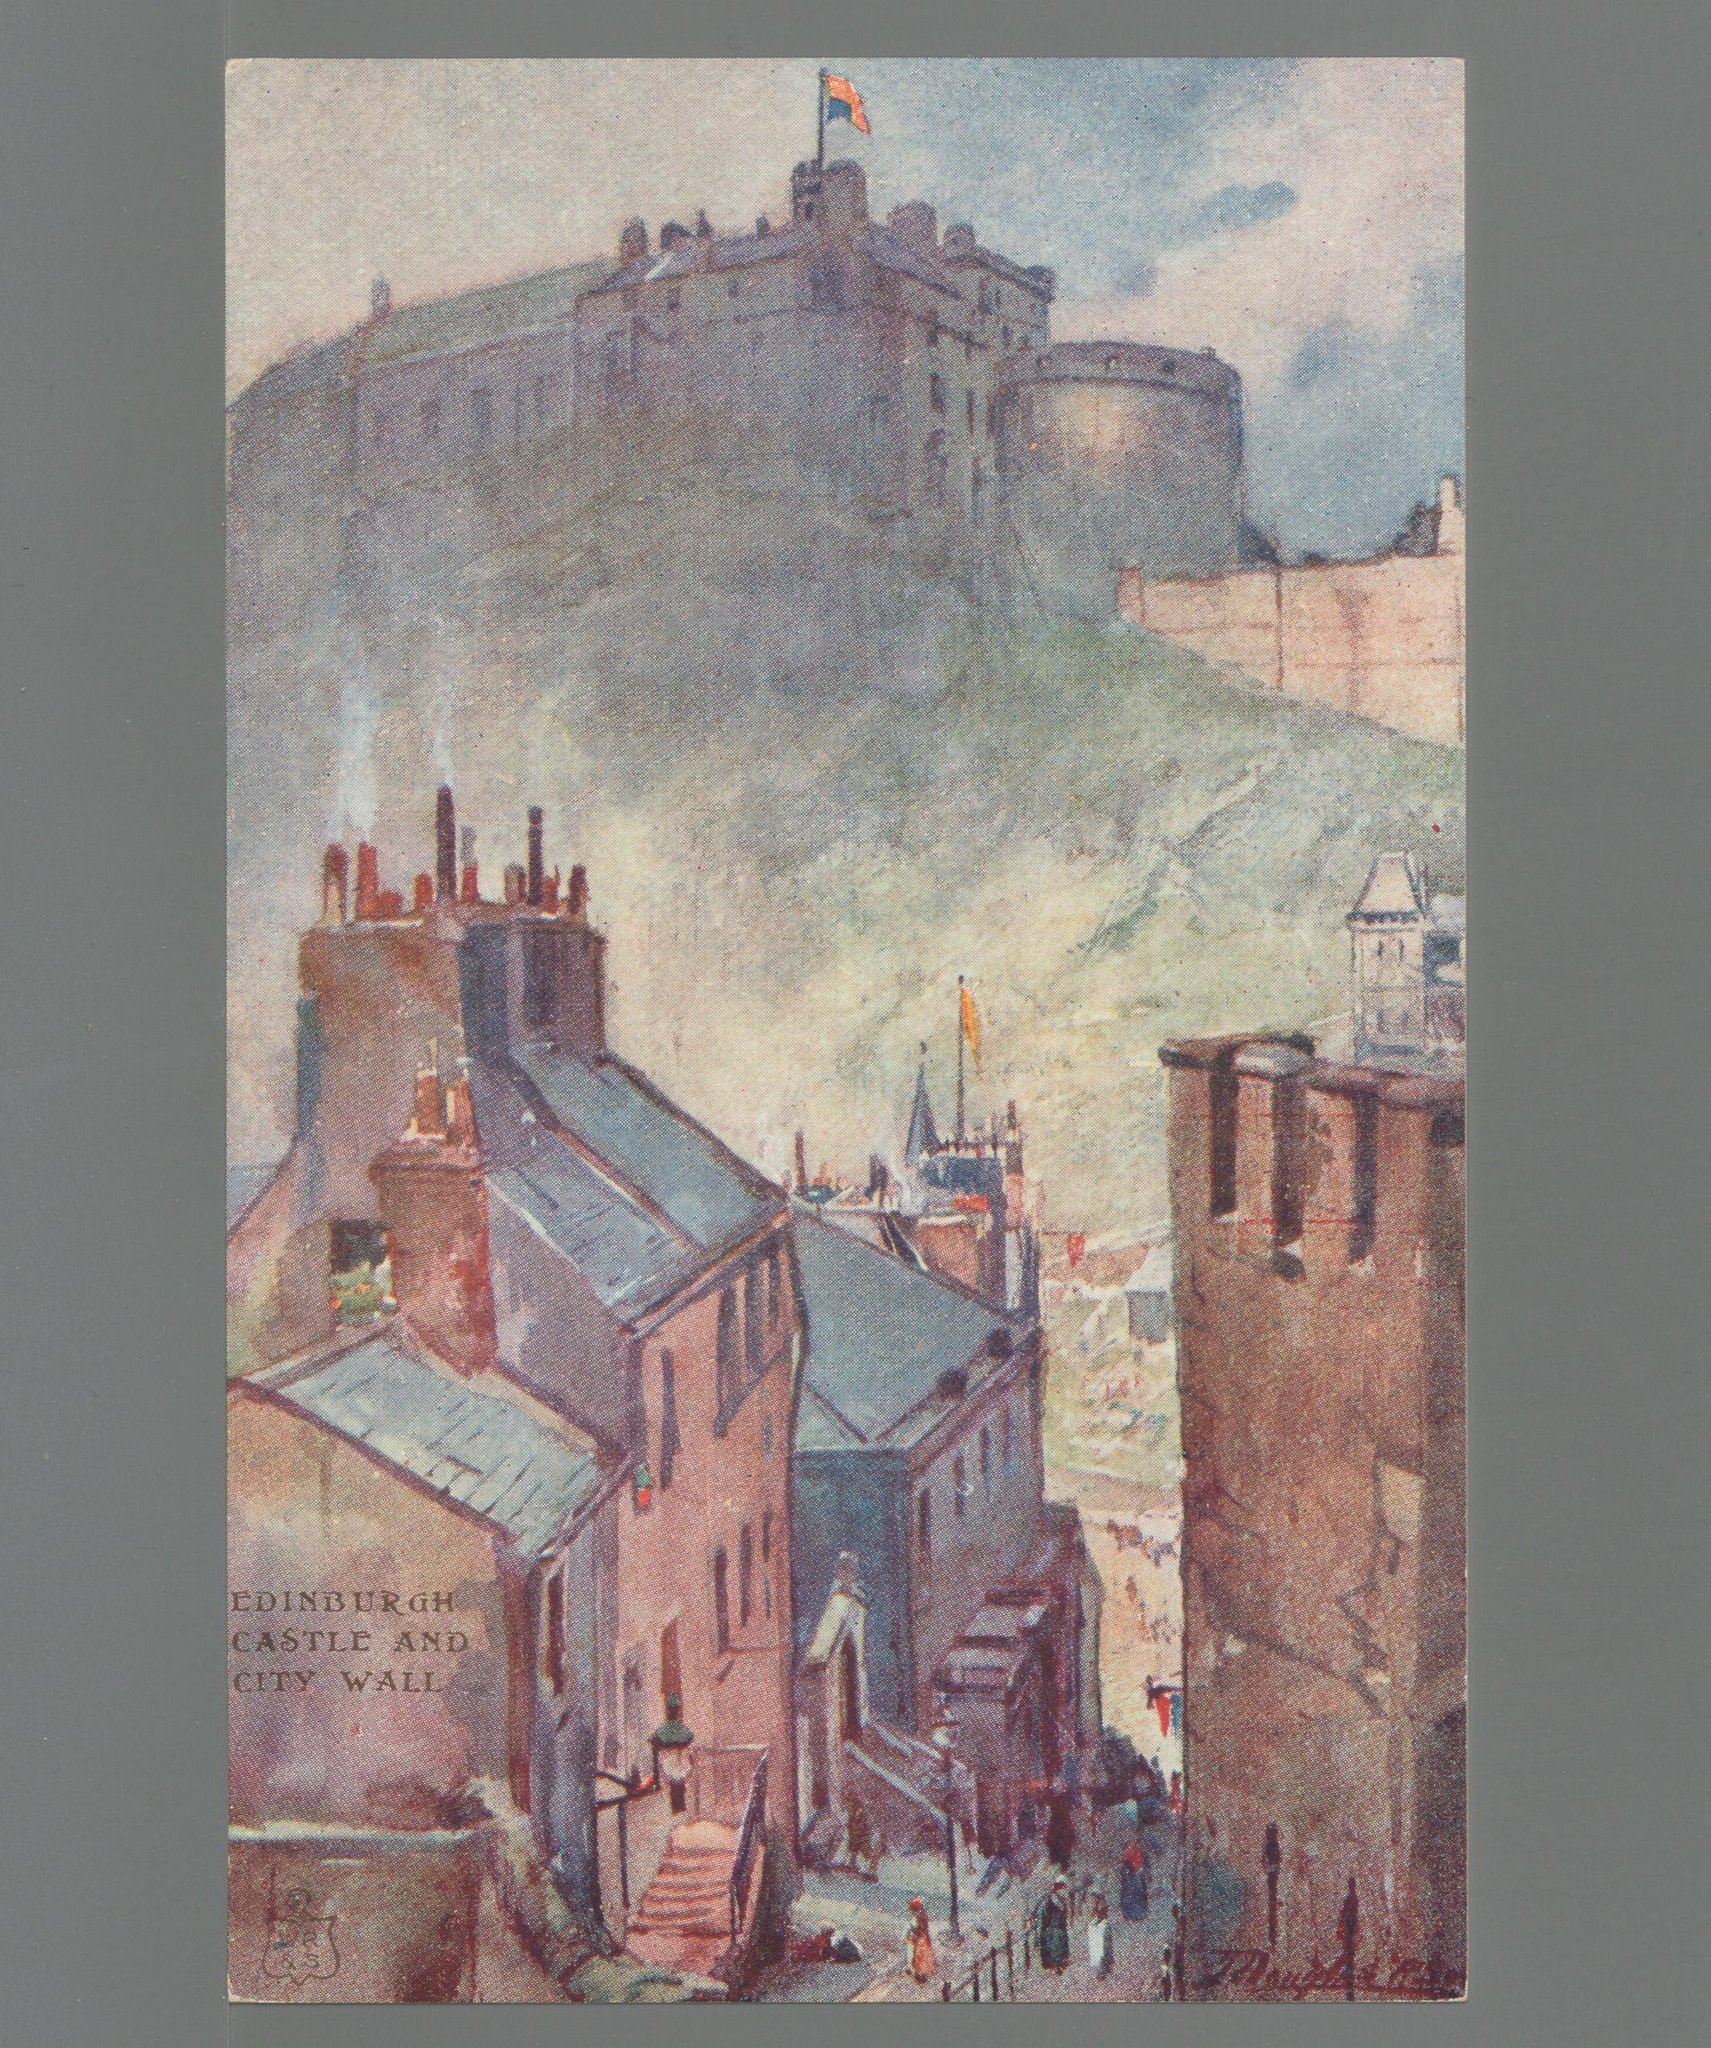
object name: reproduction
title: Edinburgh Castle and City Wall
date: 1903-1918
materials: cardboard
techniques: color autotype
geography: edinburgh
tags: castle, city-walls